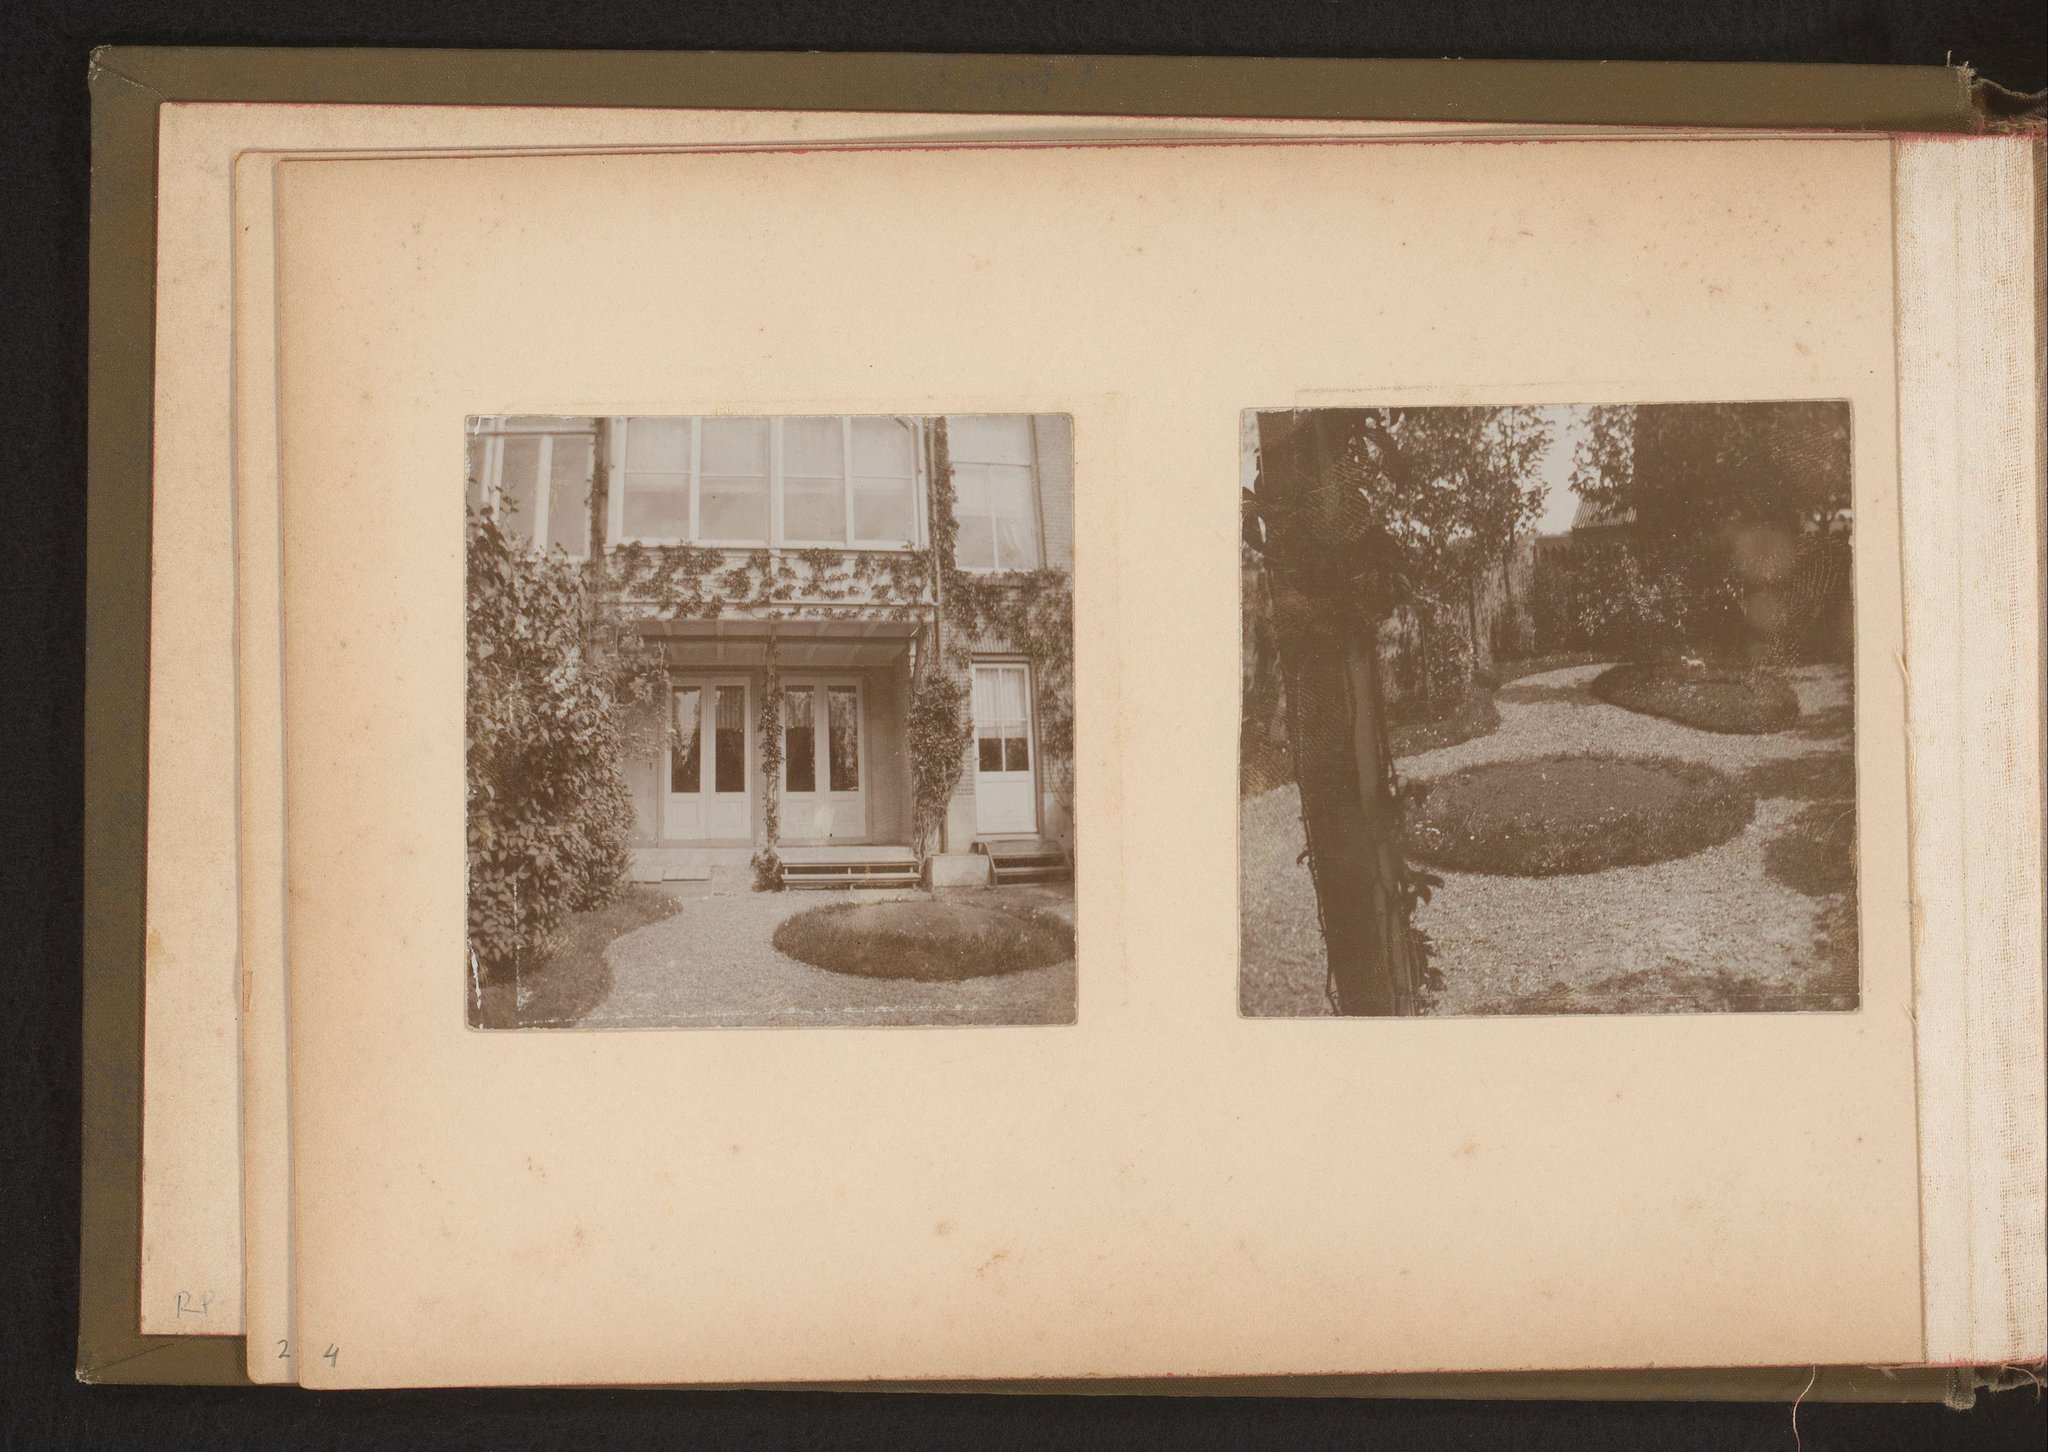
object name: photograph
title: Twee foto's van een tuin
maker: Anonymous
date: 1895-1910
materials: paper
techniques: collodion silver print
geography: amsterdam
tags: garden, amsterdam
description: Deze foto's maken deel uit van een album.